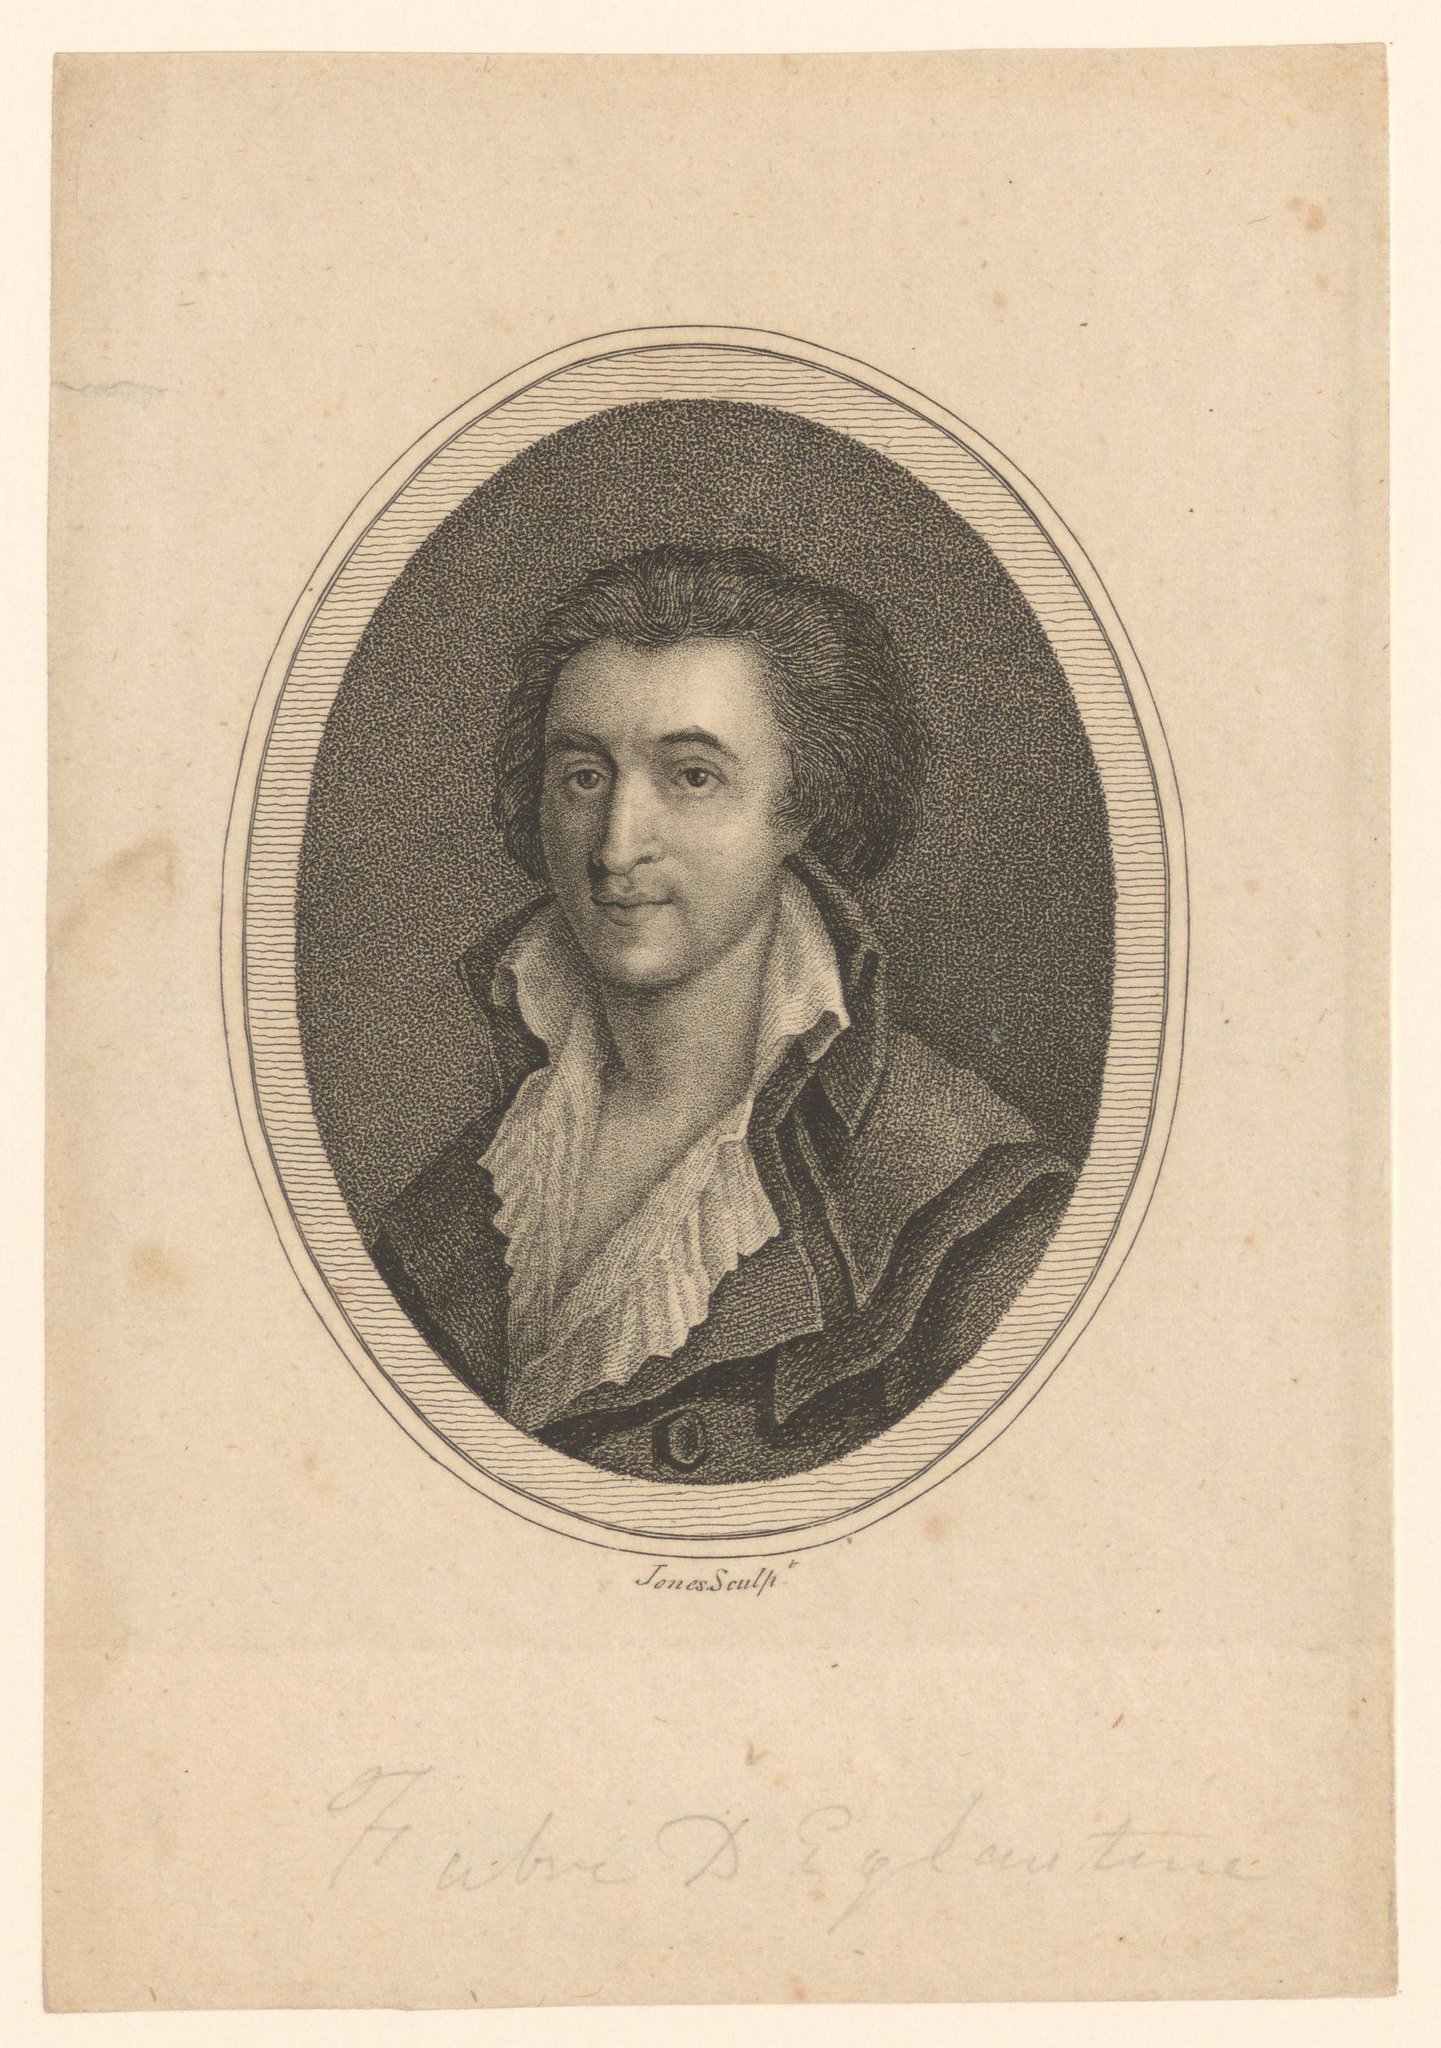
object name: print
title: Portret van Charles Colbert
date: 1792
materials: paper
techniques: etching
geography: england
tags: historical persons, politician, e.g. party leader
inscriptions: collector's mark: Lugt 2228